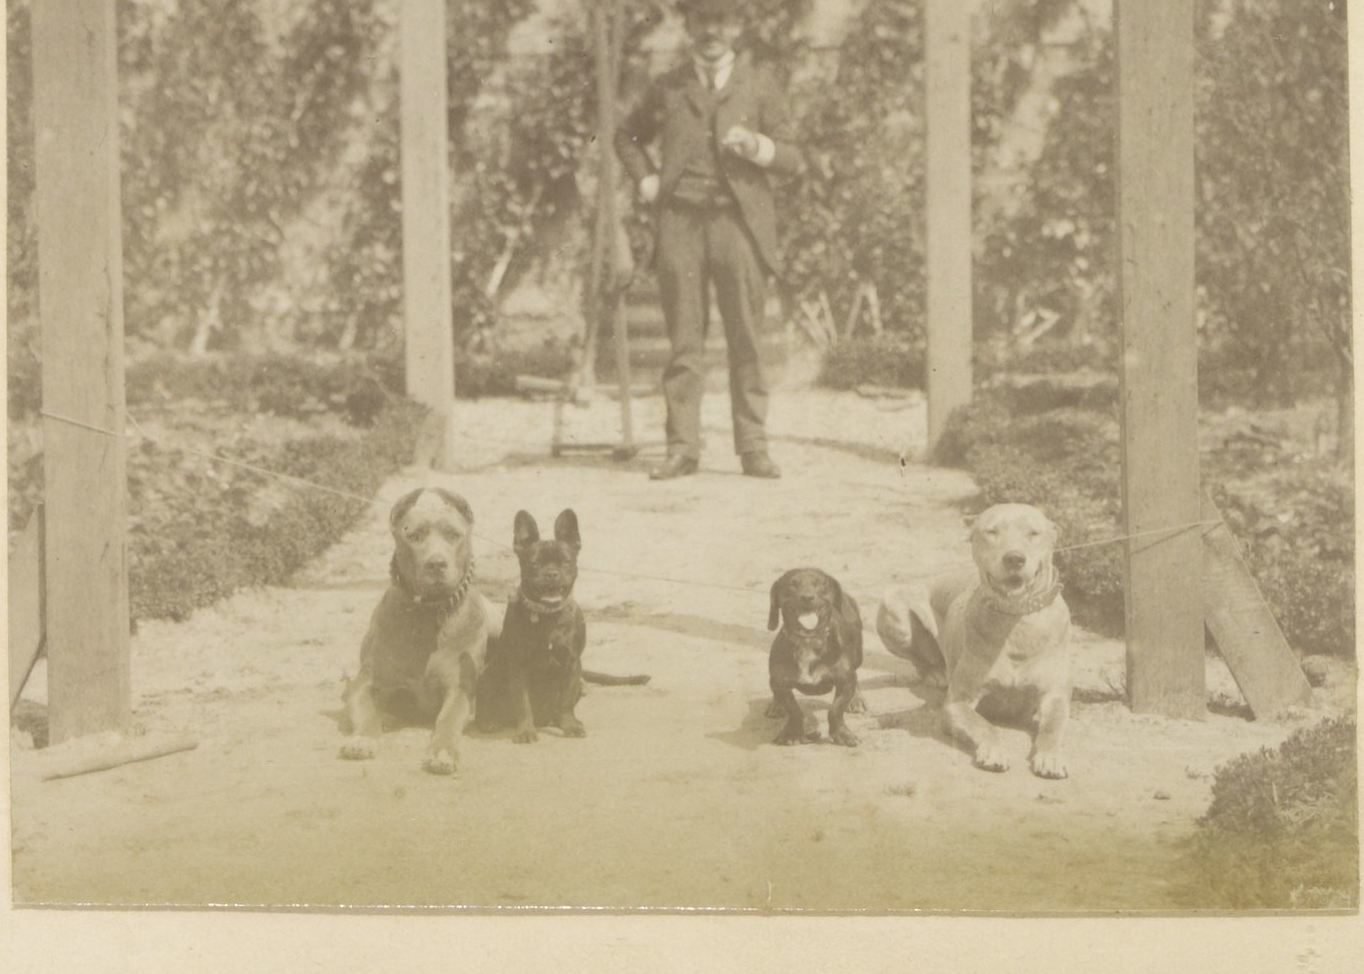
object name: photograph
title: Vier honden en een man op een tuinpad in Frankrijk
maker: Anonymous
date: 1900-1910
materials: paper, photographic support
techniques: albumen print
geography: france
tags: garden, adult man, dog, france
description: Onderdeel van Fotoalbum van een Franse amateurfotograaf met opnames van een familie, distilleerderij Delizy & Doistau Fils, het leger en bezienswaardigheden in Frankrijk.